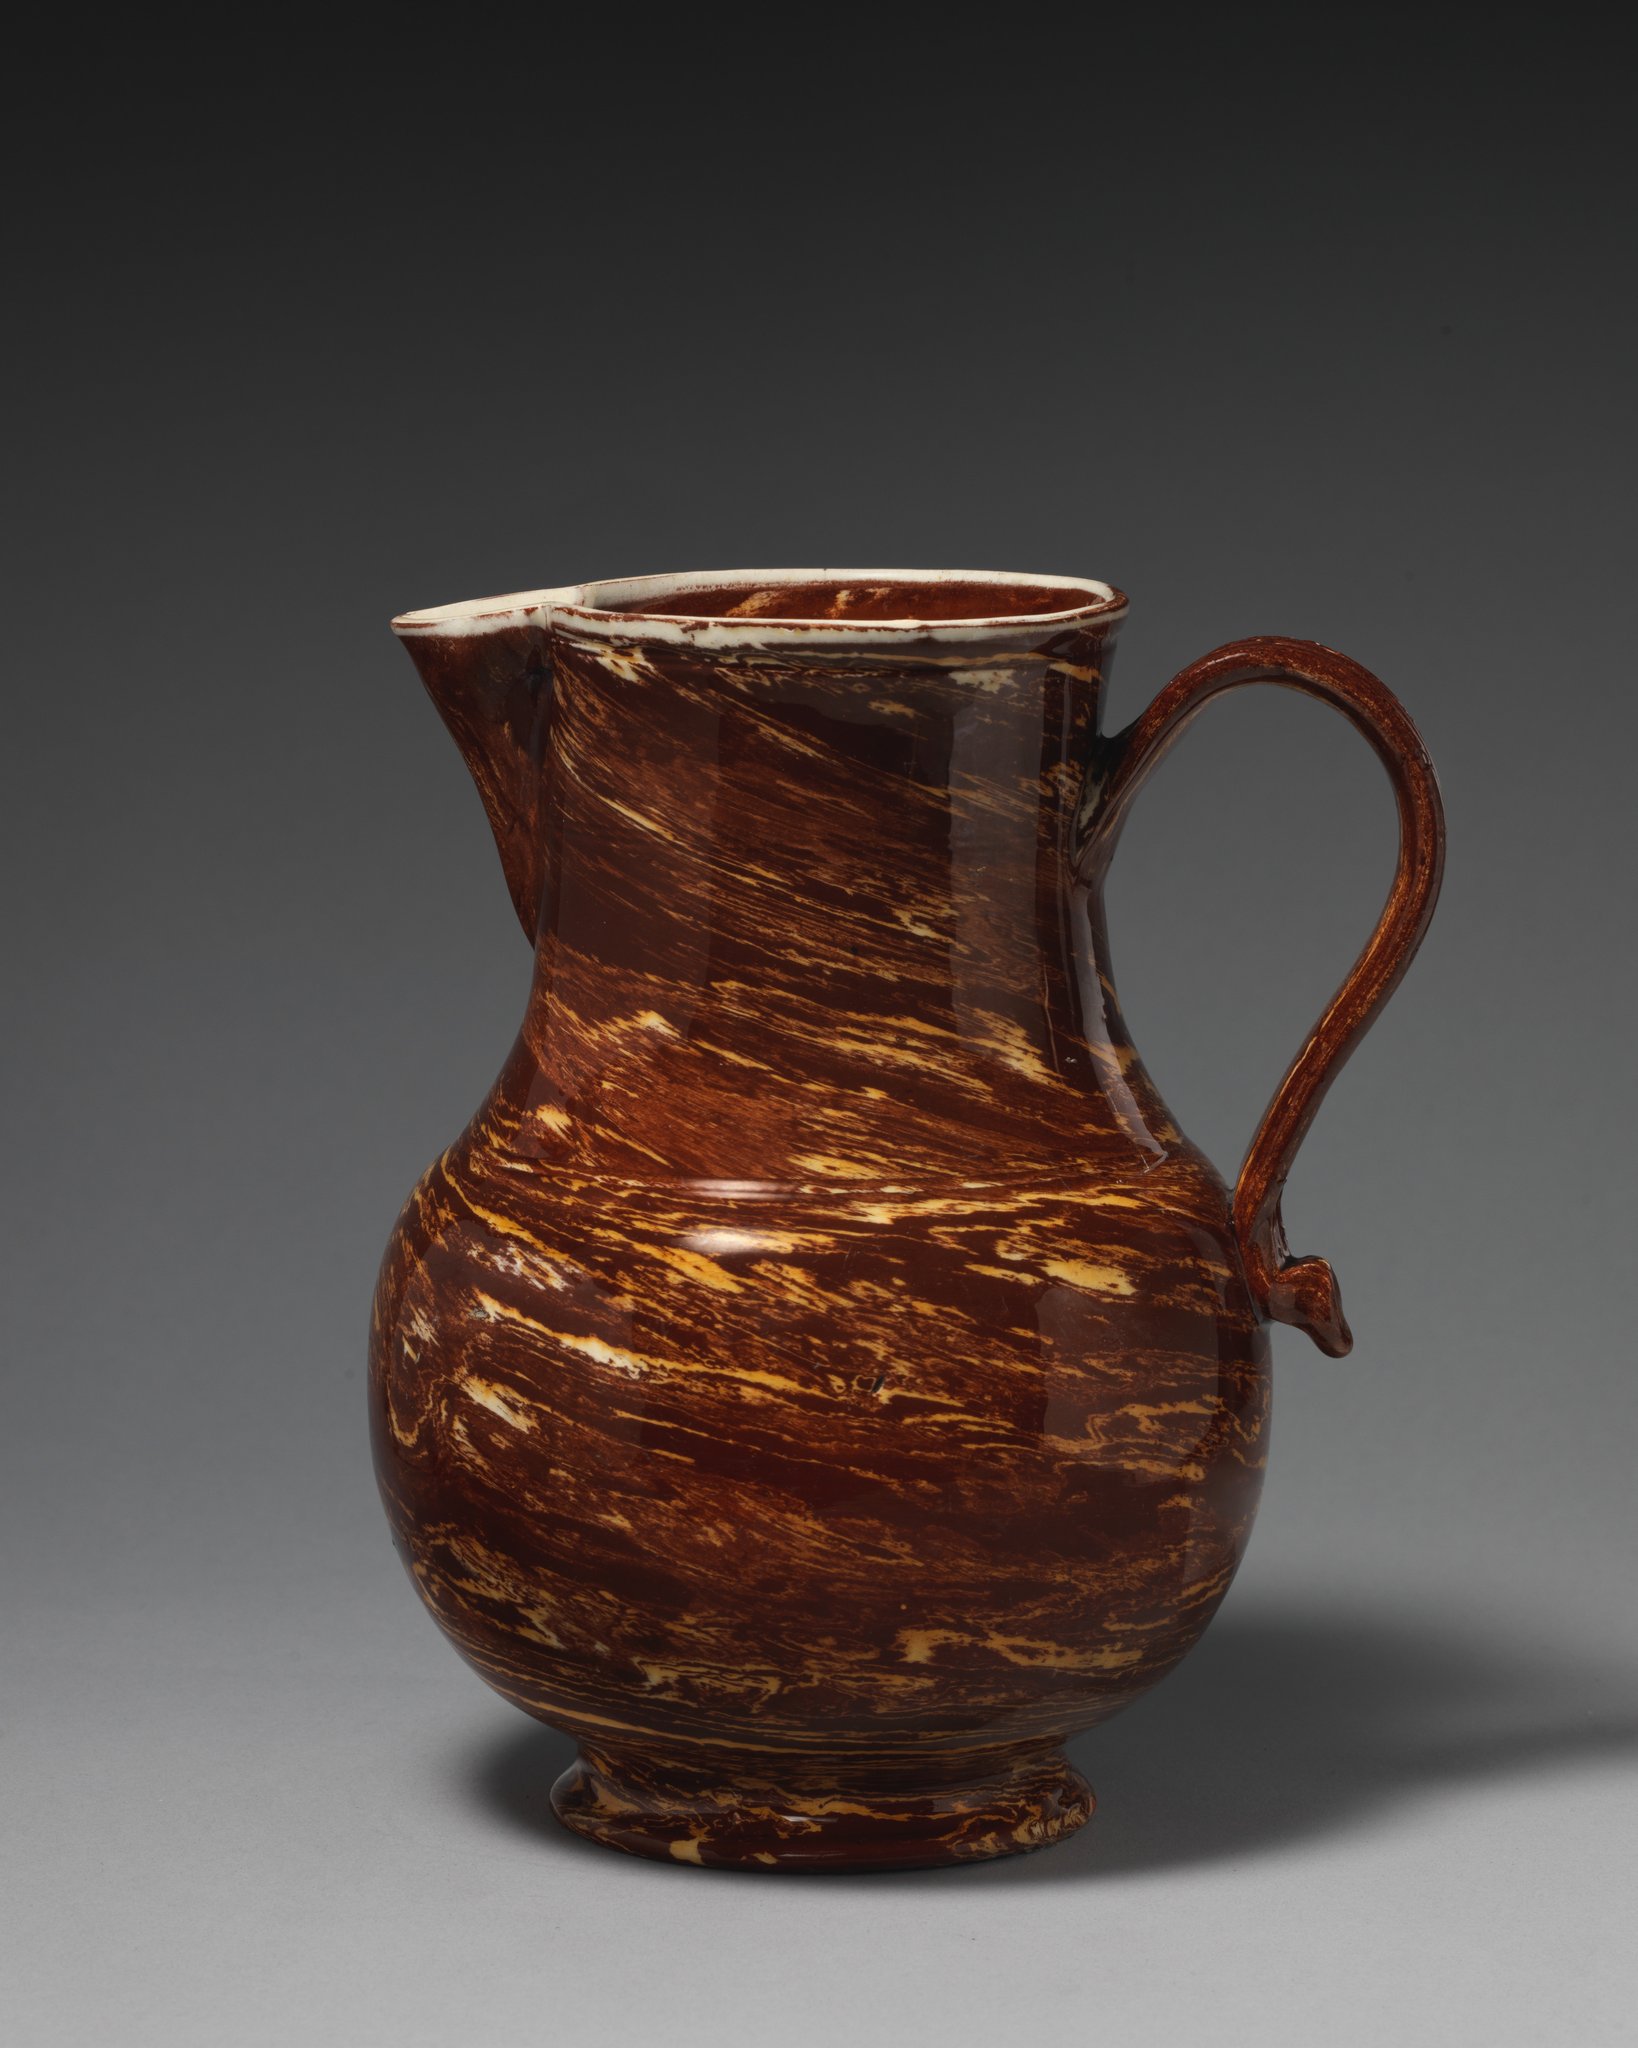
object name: jug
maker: john astbury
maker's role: maker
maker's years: 1688-1743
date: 1745